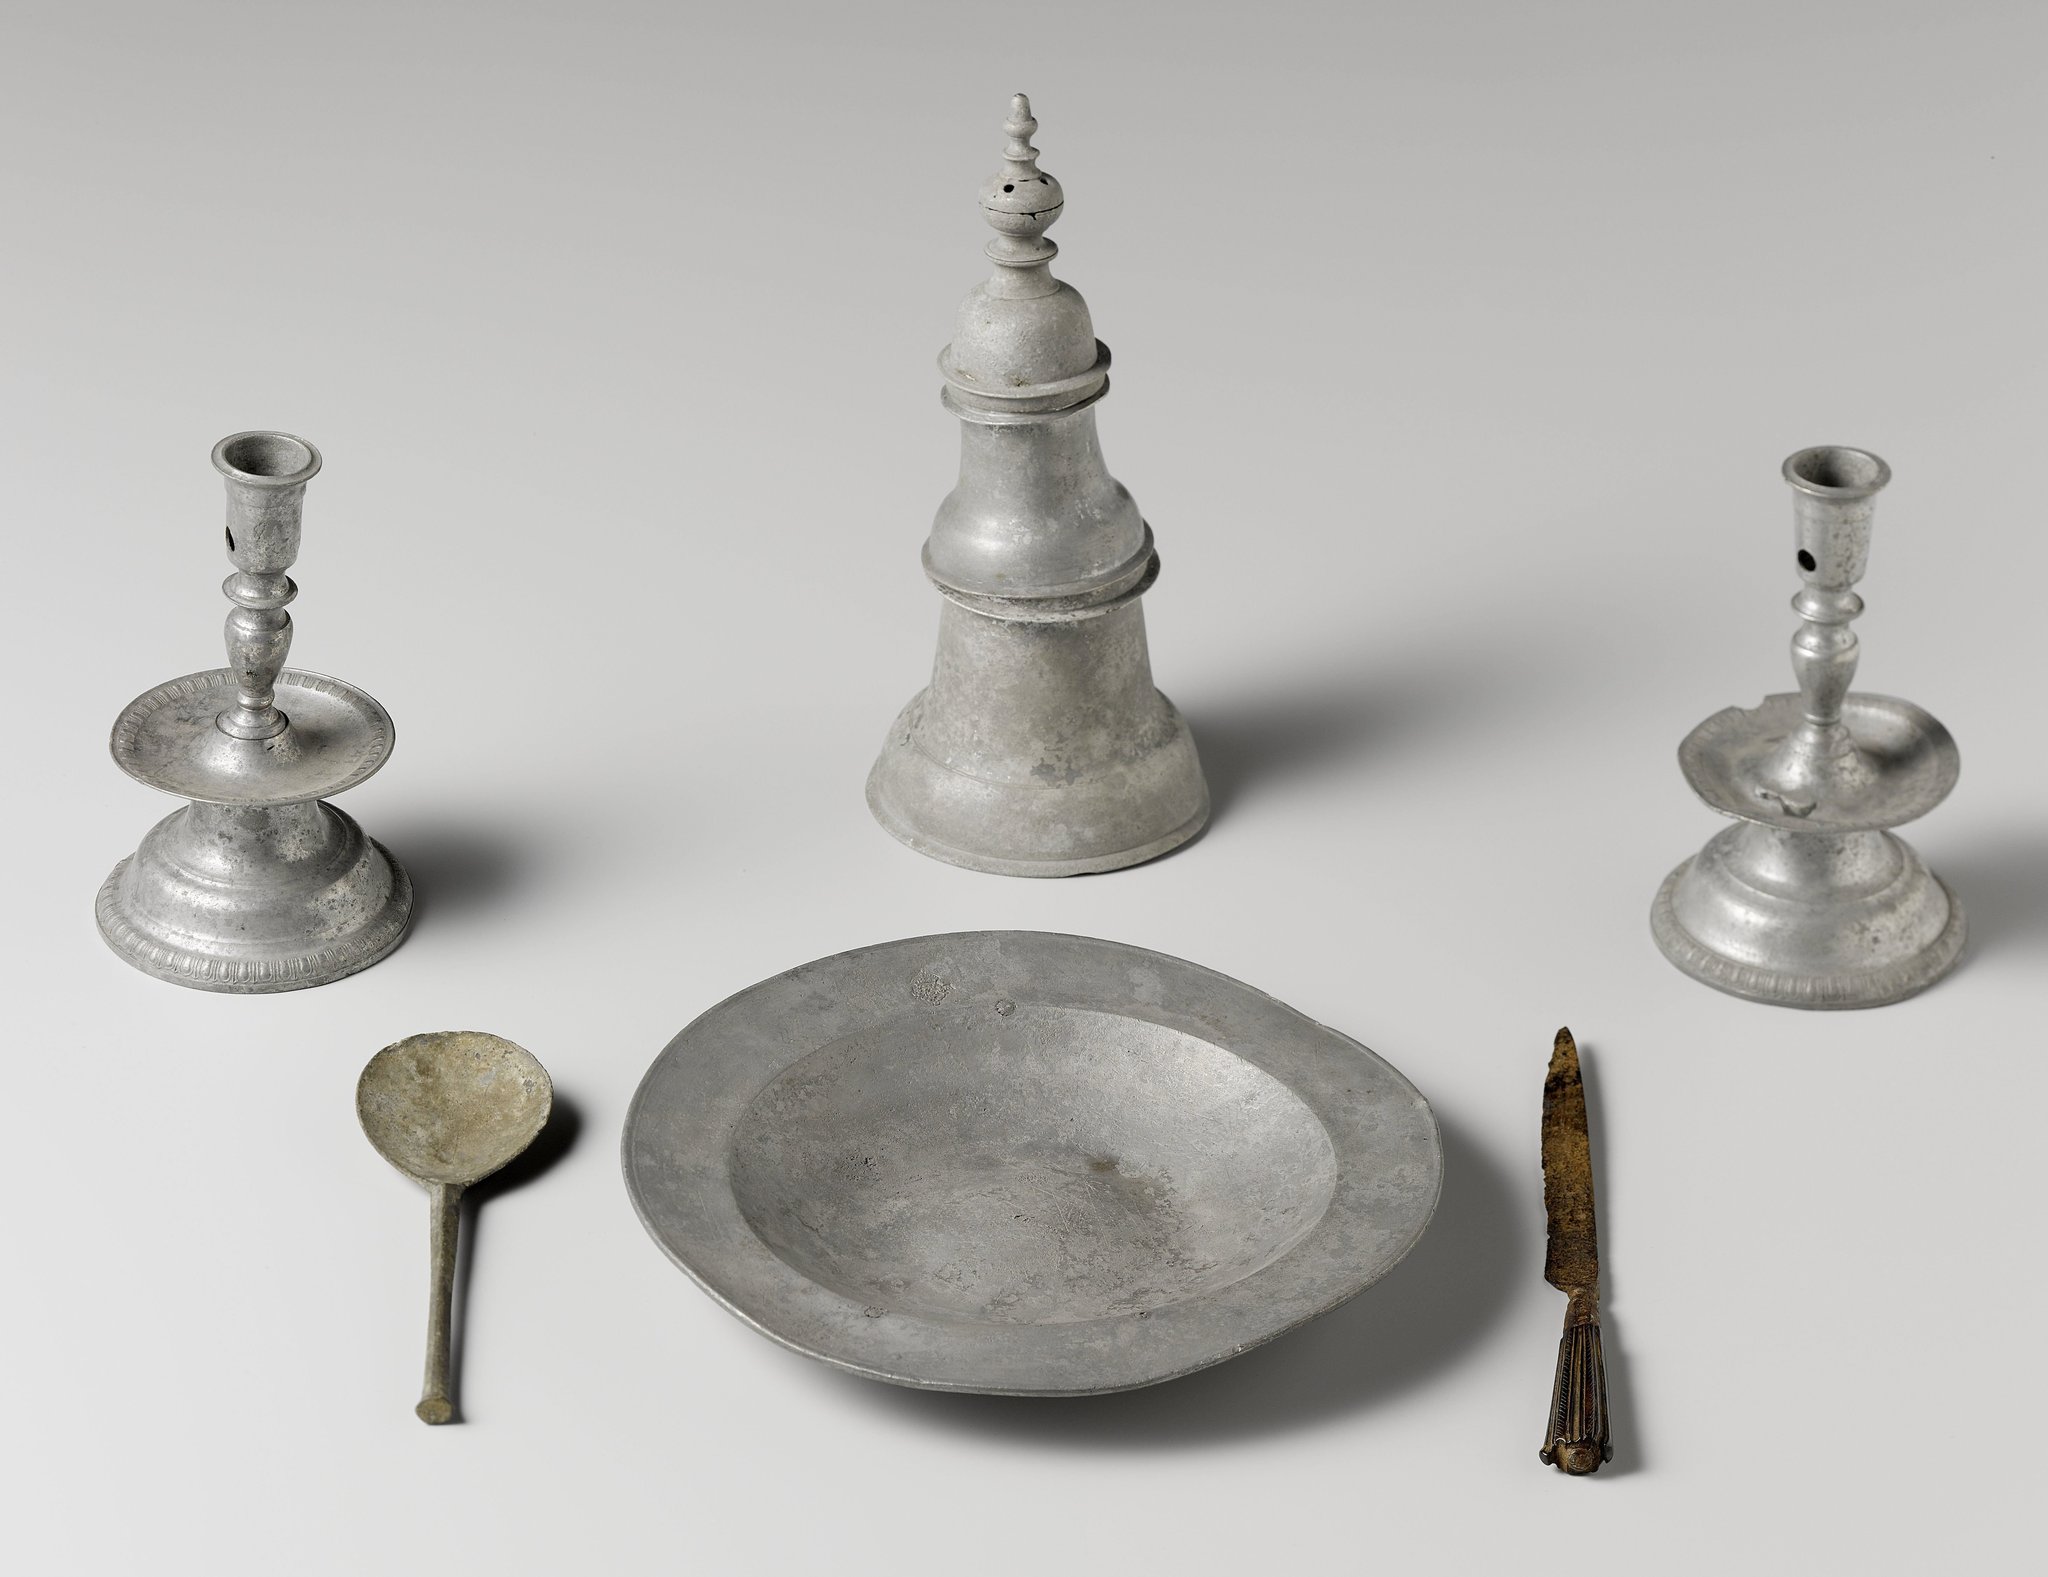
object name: dobbelier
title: Tinnen bord met een weinig gewelfde bodem, een smal boord met een opstaand profieltje en een sierrand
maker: aelbert claesz (ac)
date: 1590-1596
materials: tin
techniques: casting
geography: amsterdam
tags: willem barendsz., amsterdam, jacob van heemskerck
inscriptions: mark, mark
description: Pewter/Tin plate